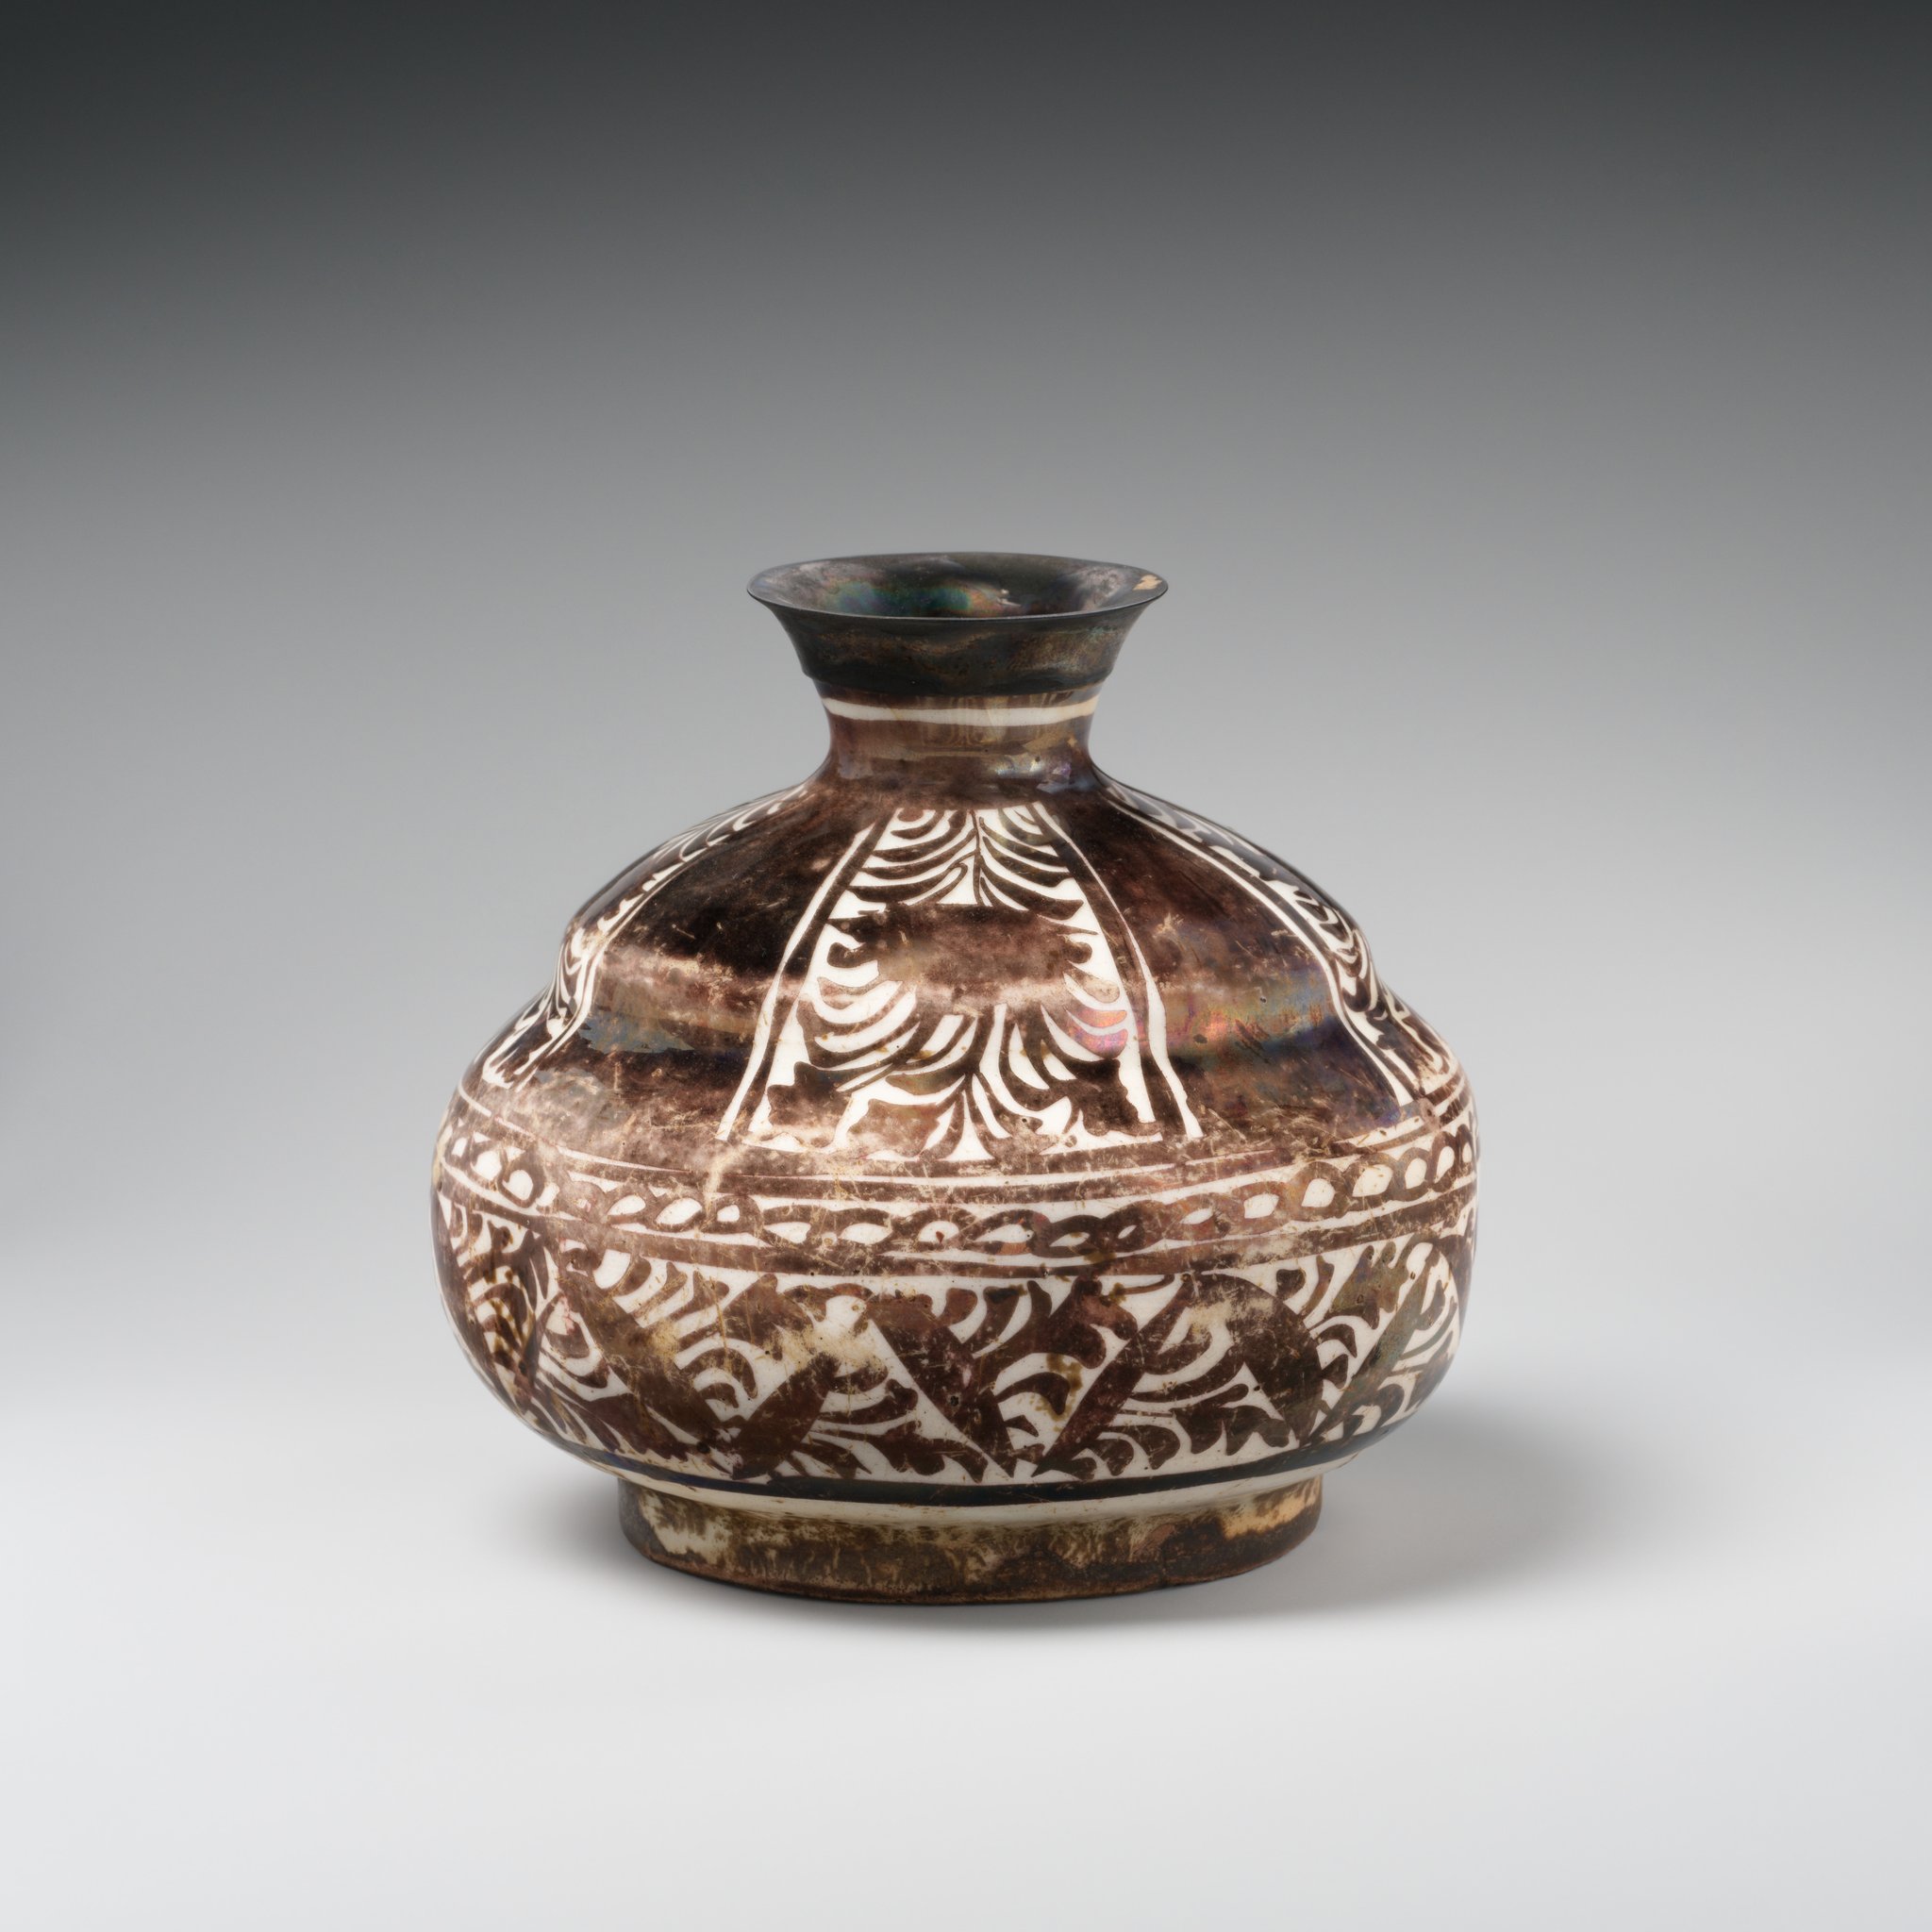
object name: jar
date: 1601-1700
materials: glaze, stonepaste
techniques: luster painting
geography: iran